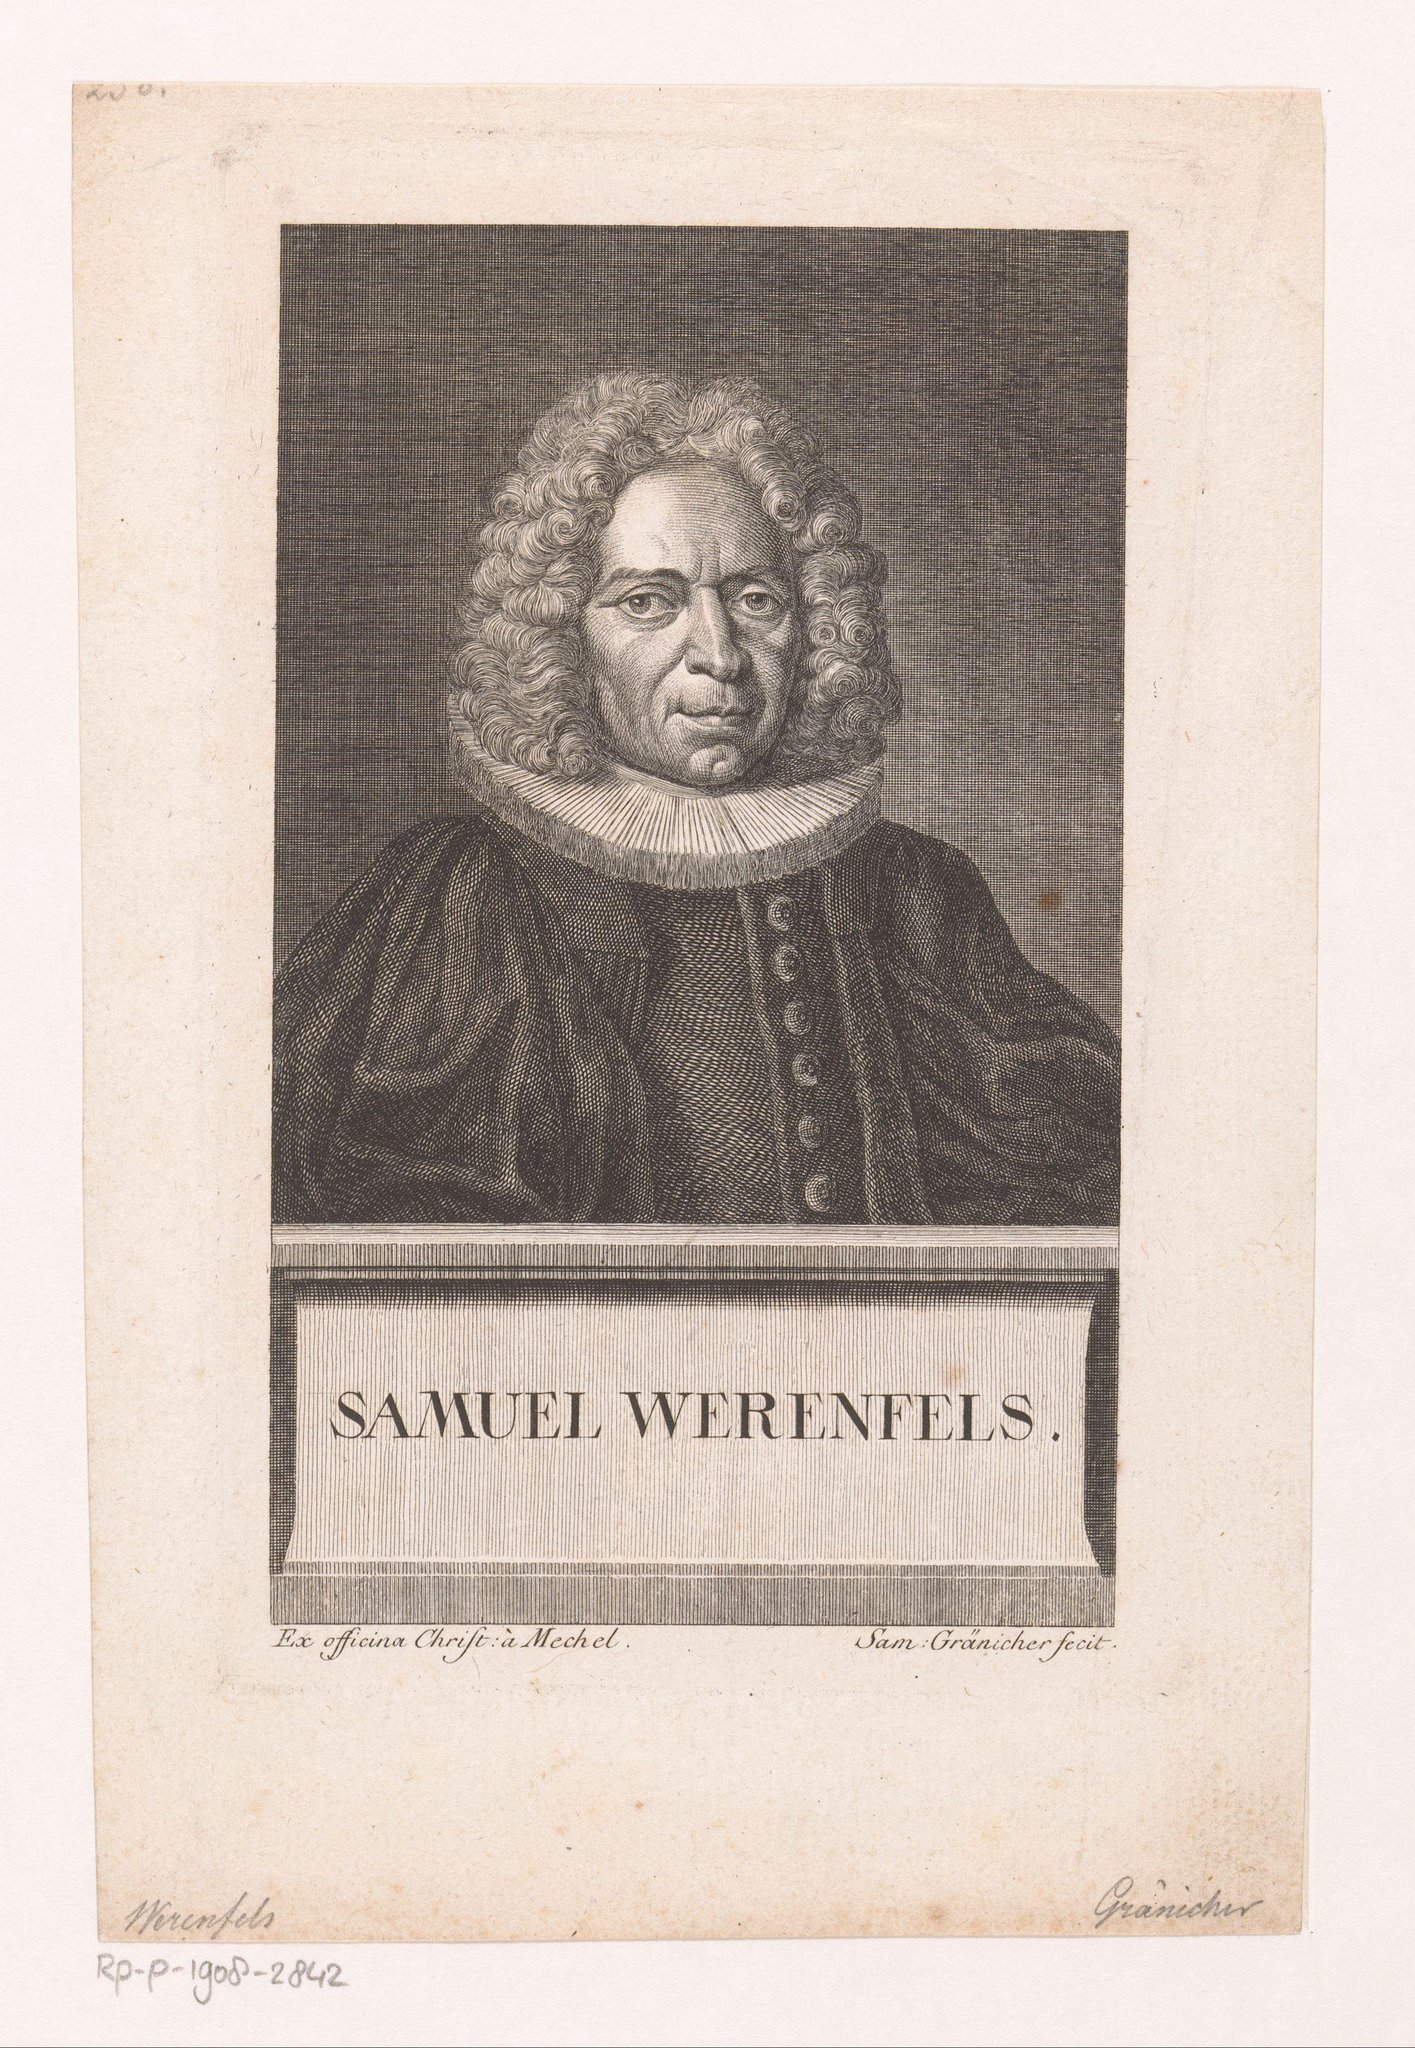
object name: print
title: Portret van Samuel Werenfels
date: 1768-1813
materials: paper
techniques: engraving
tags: theologian, historical persons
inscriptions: collector's mark: Lugt 2228